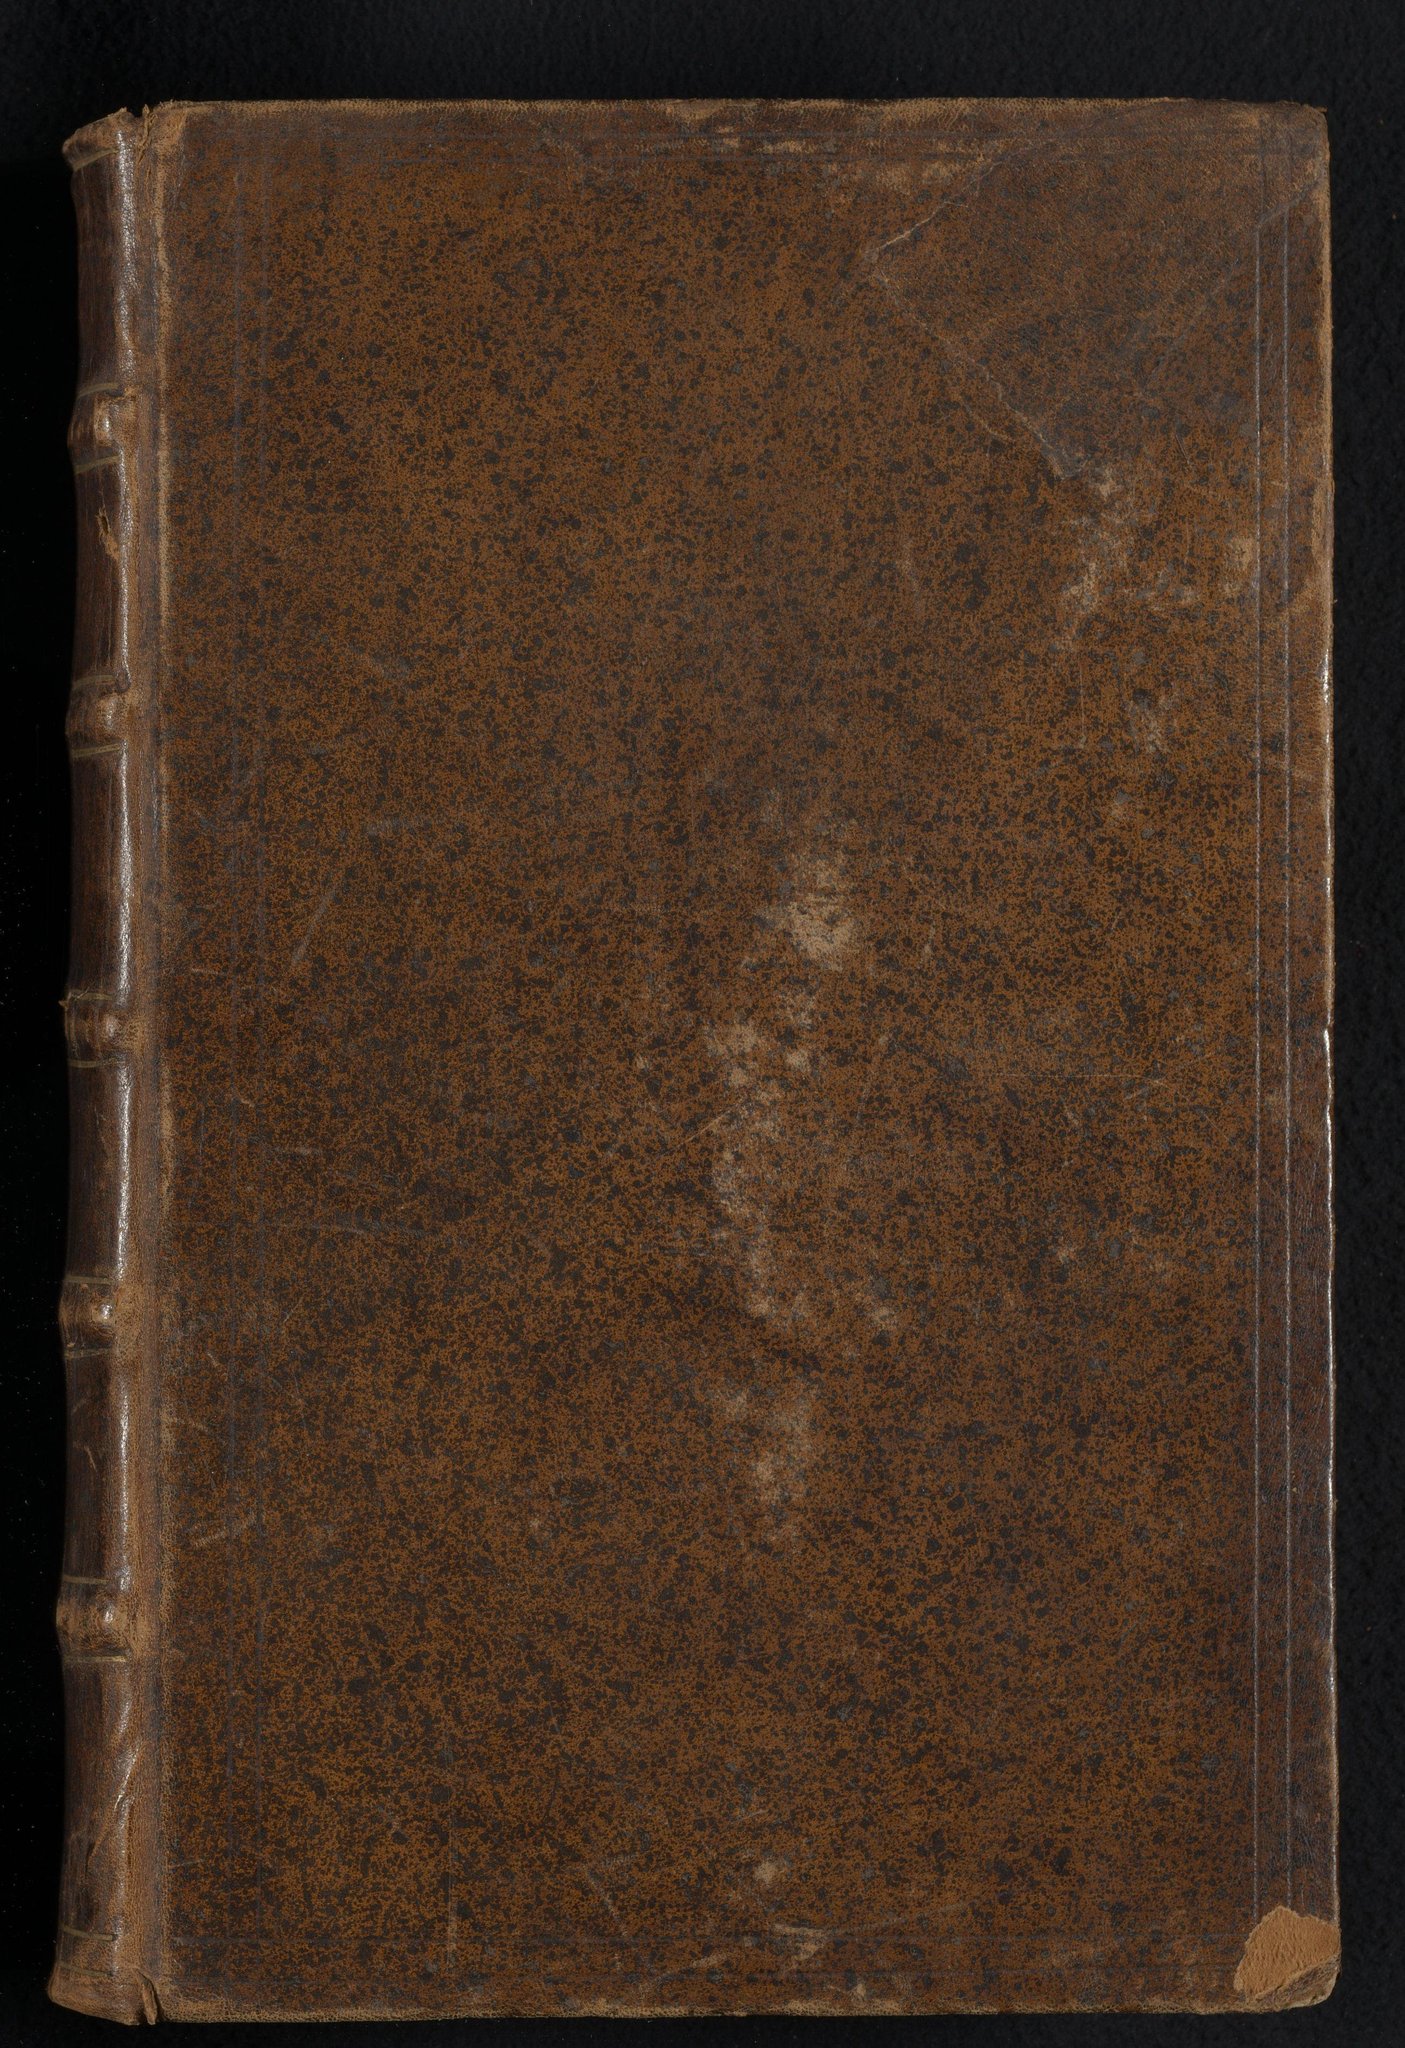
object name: book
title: Wapen boeck ten deele vergadert door Johan van Gendt en nu verder volmaakt door sijn soon Gerlach van Gendt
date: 1630-1730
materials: leather, gold leaf, ink, paint, paper, pencil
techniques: bookbinding, printing, brush, pen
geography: nijmegen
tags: armorial bearing, heraldry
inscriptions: collector's mark: Lugt 2166, collector's mark: ‘De Roye Van Wichen - Luite Kolonel - Generalen staf.’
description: Wapenboek bestaande uit een titelblad en 368 bladen (gefolieerd), waarvan 328 bladen vijf getekende wapenschilden bevatten op zowel recto als verso (tien wapenschilden per blad). Blad 329 heeft enkel de wapenschilden op recto ingeschilderd: de wapenschilden op verso zijn blanco. Blad 330 tot en met 349 bevat blanco wapenschilden. In totaal bevat dit boek 3285 Nederlandse en Vlaamse familiewapens, elk met de familienaam onder het wapenschild, en 205 blanco wapenschilden. Van blad 350 tot en met 364 loopt een register van de familienamen. De overige bladen zijn blanco. Op verso van het schutblad voorin is een blad geplakt met handgeschreven tekst, gedateerd 1832, met een korte biografie van de familie van Gendt en in het bijzonder Johan en Gerlach van Gendt, de makers van dit wapenboek.